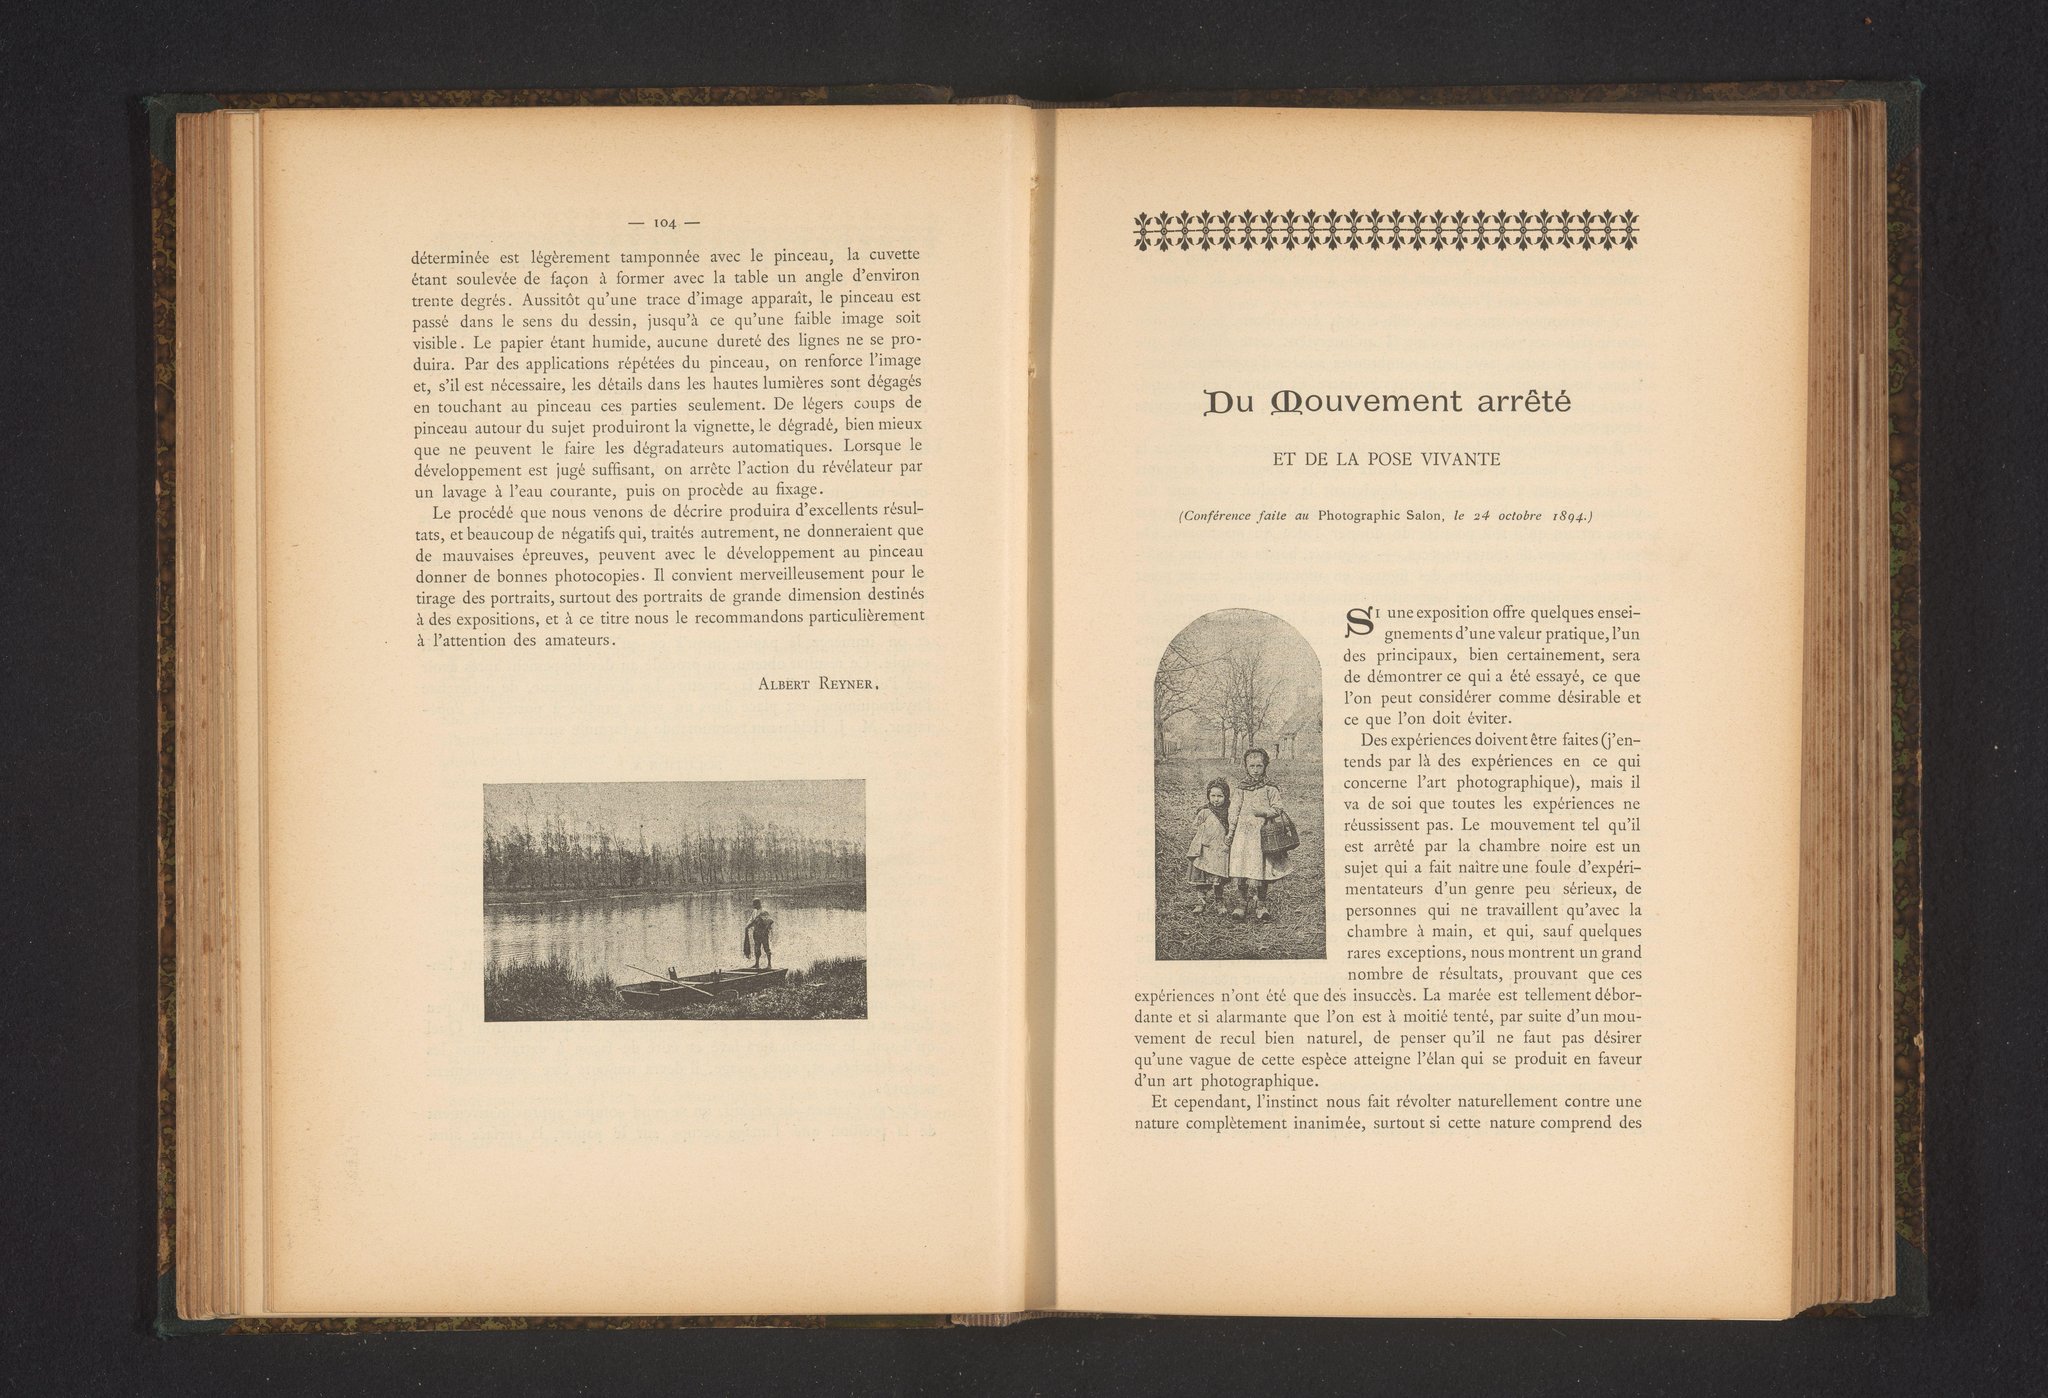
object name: page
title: Man bij een roeiboot aan de waterkant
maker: Anonymous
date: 1890-1895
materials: paper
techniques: photograph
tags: river bank, adult man, rowing-boat, canoe, etc.